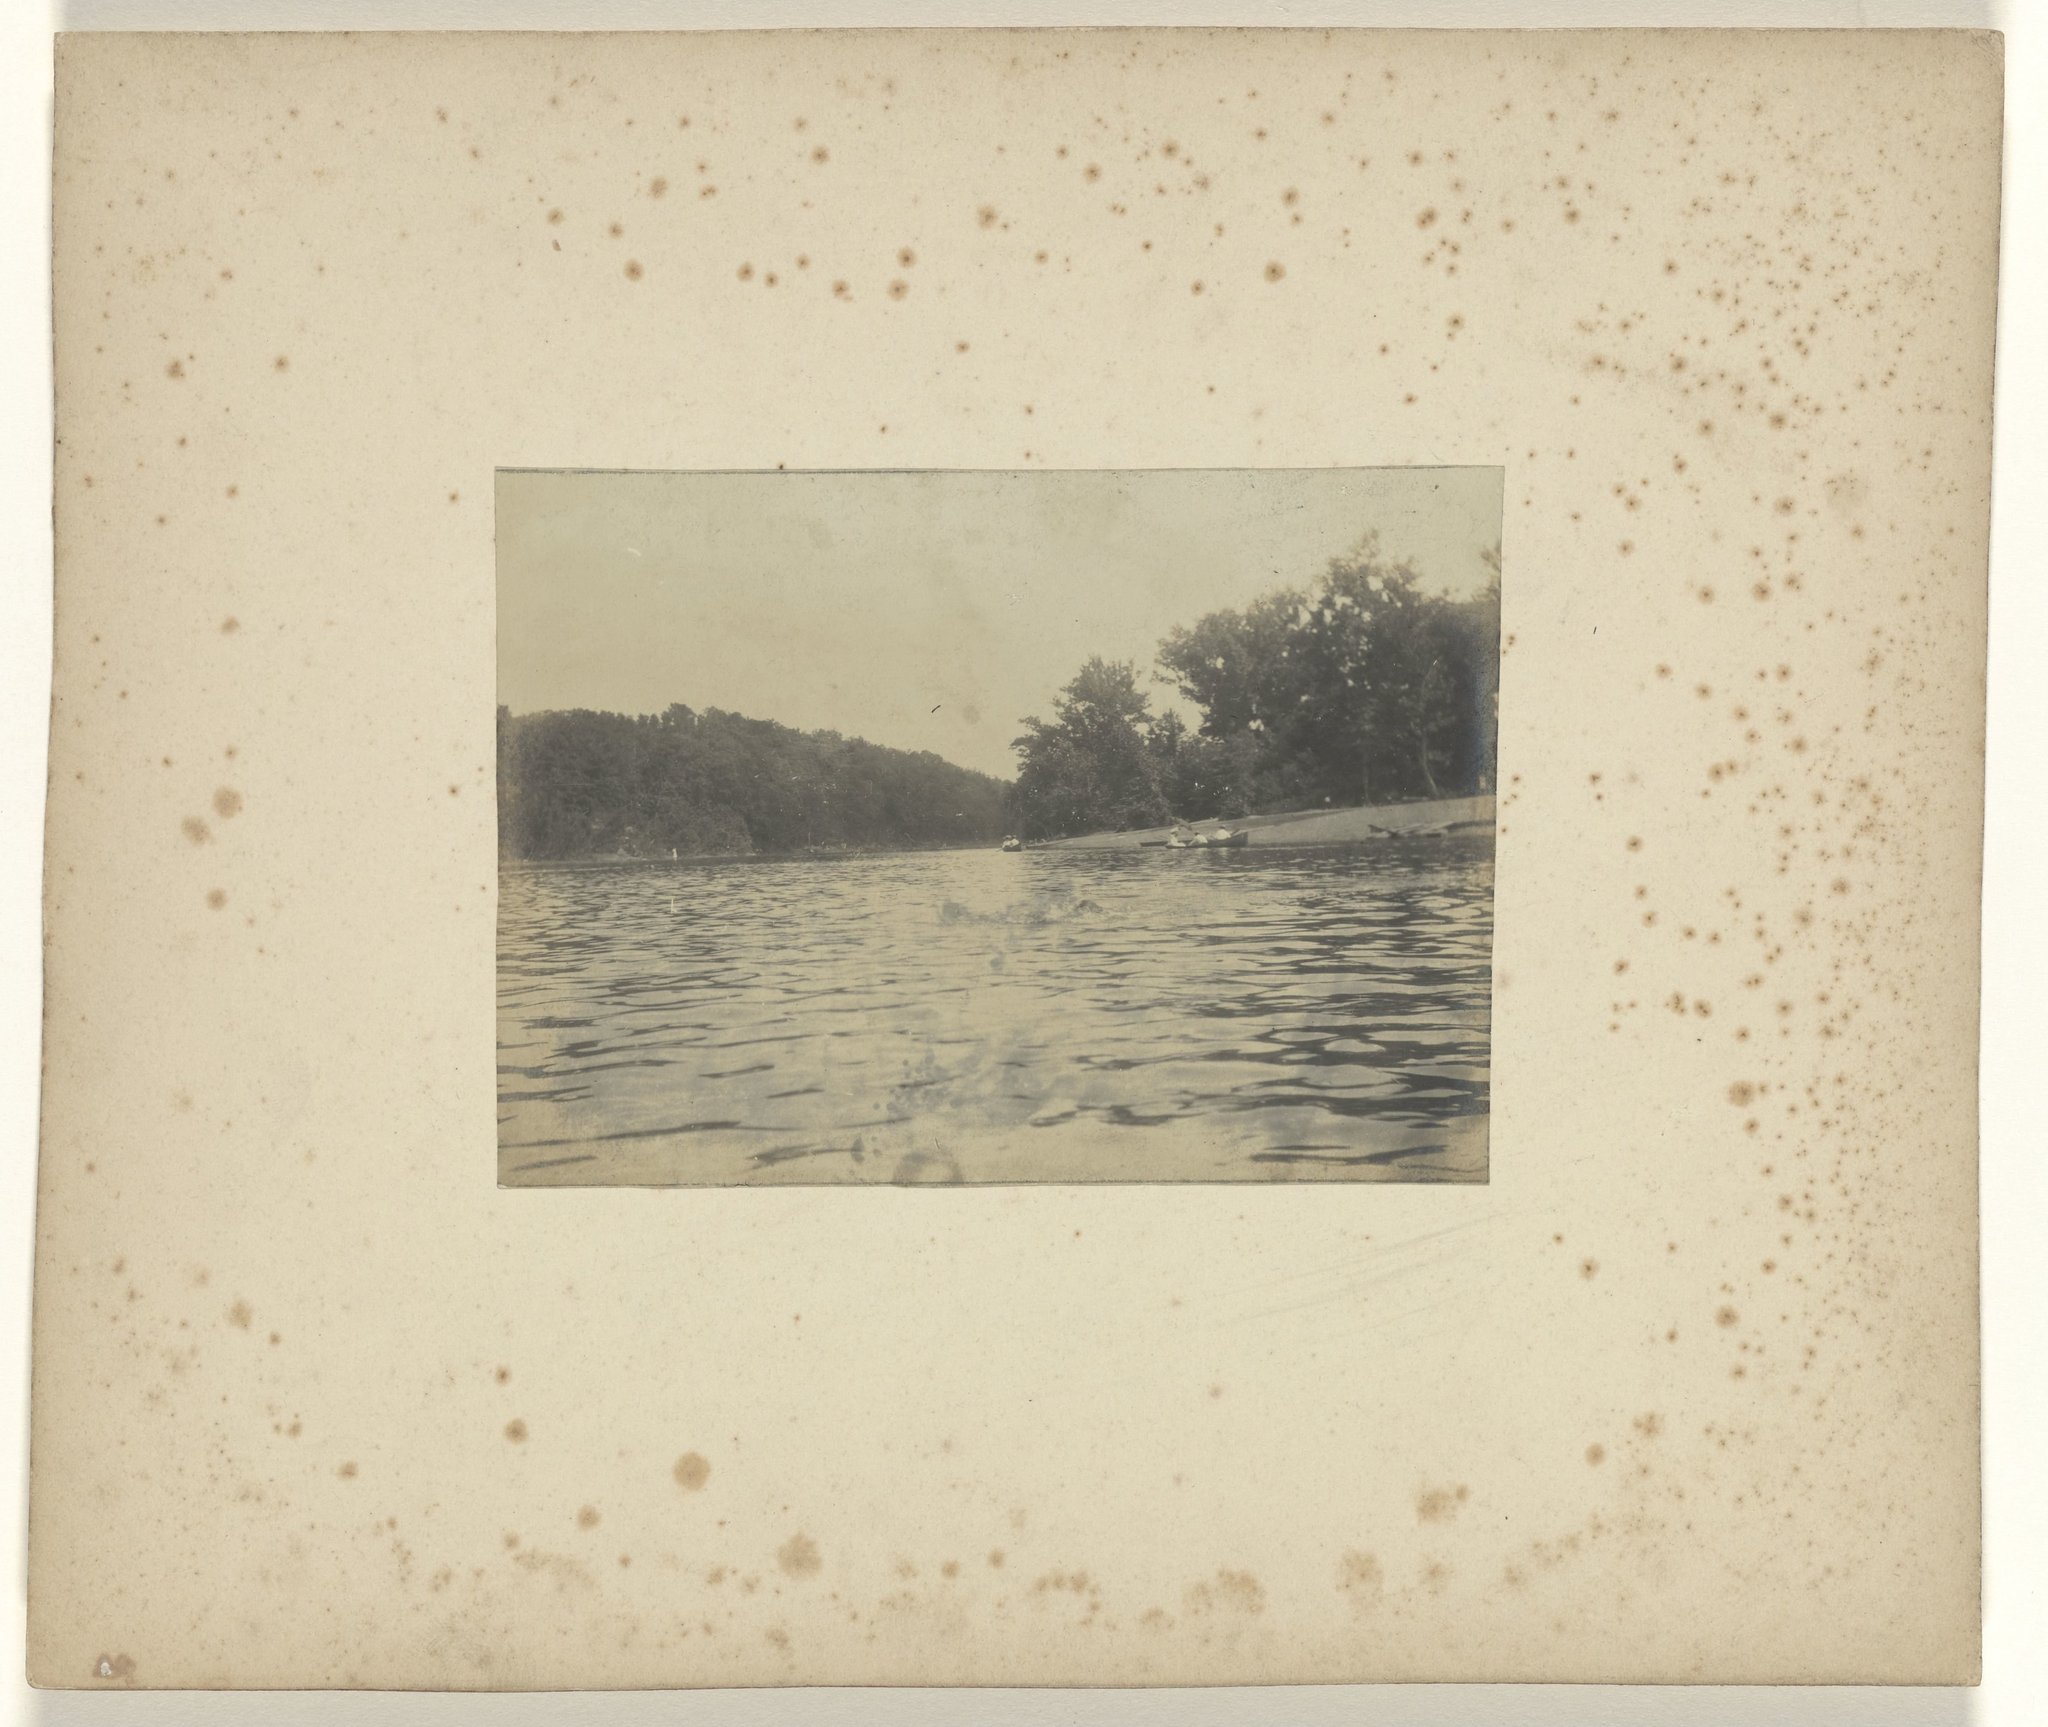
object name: photograph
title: Roeiboten en een zwemmer, Meramec rivier, tijdens de wereldtentoonstelling in St. Louis (Louisiana Purchase Exposition), 1904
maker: jan schüller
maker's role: draughtsman, painter, print maker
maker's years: 1871-1915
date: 1904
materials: cardboard, paper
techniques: gelatin silver print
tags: missouri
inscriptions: annotation: ‘Uit een roeibootje genomen op Meramec rievier [sic] // In ’t midden is een zwemmer’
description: Roeiboten en een zwemmer, Meramec rivier, tijdens de wereldtentoonstelling in St. Louis (Louisiana Purchase Exposition), 1904.